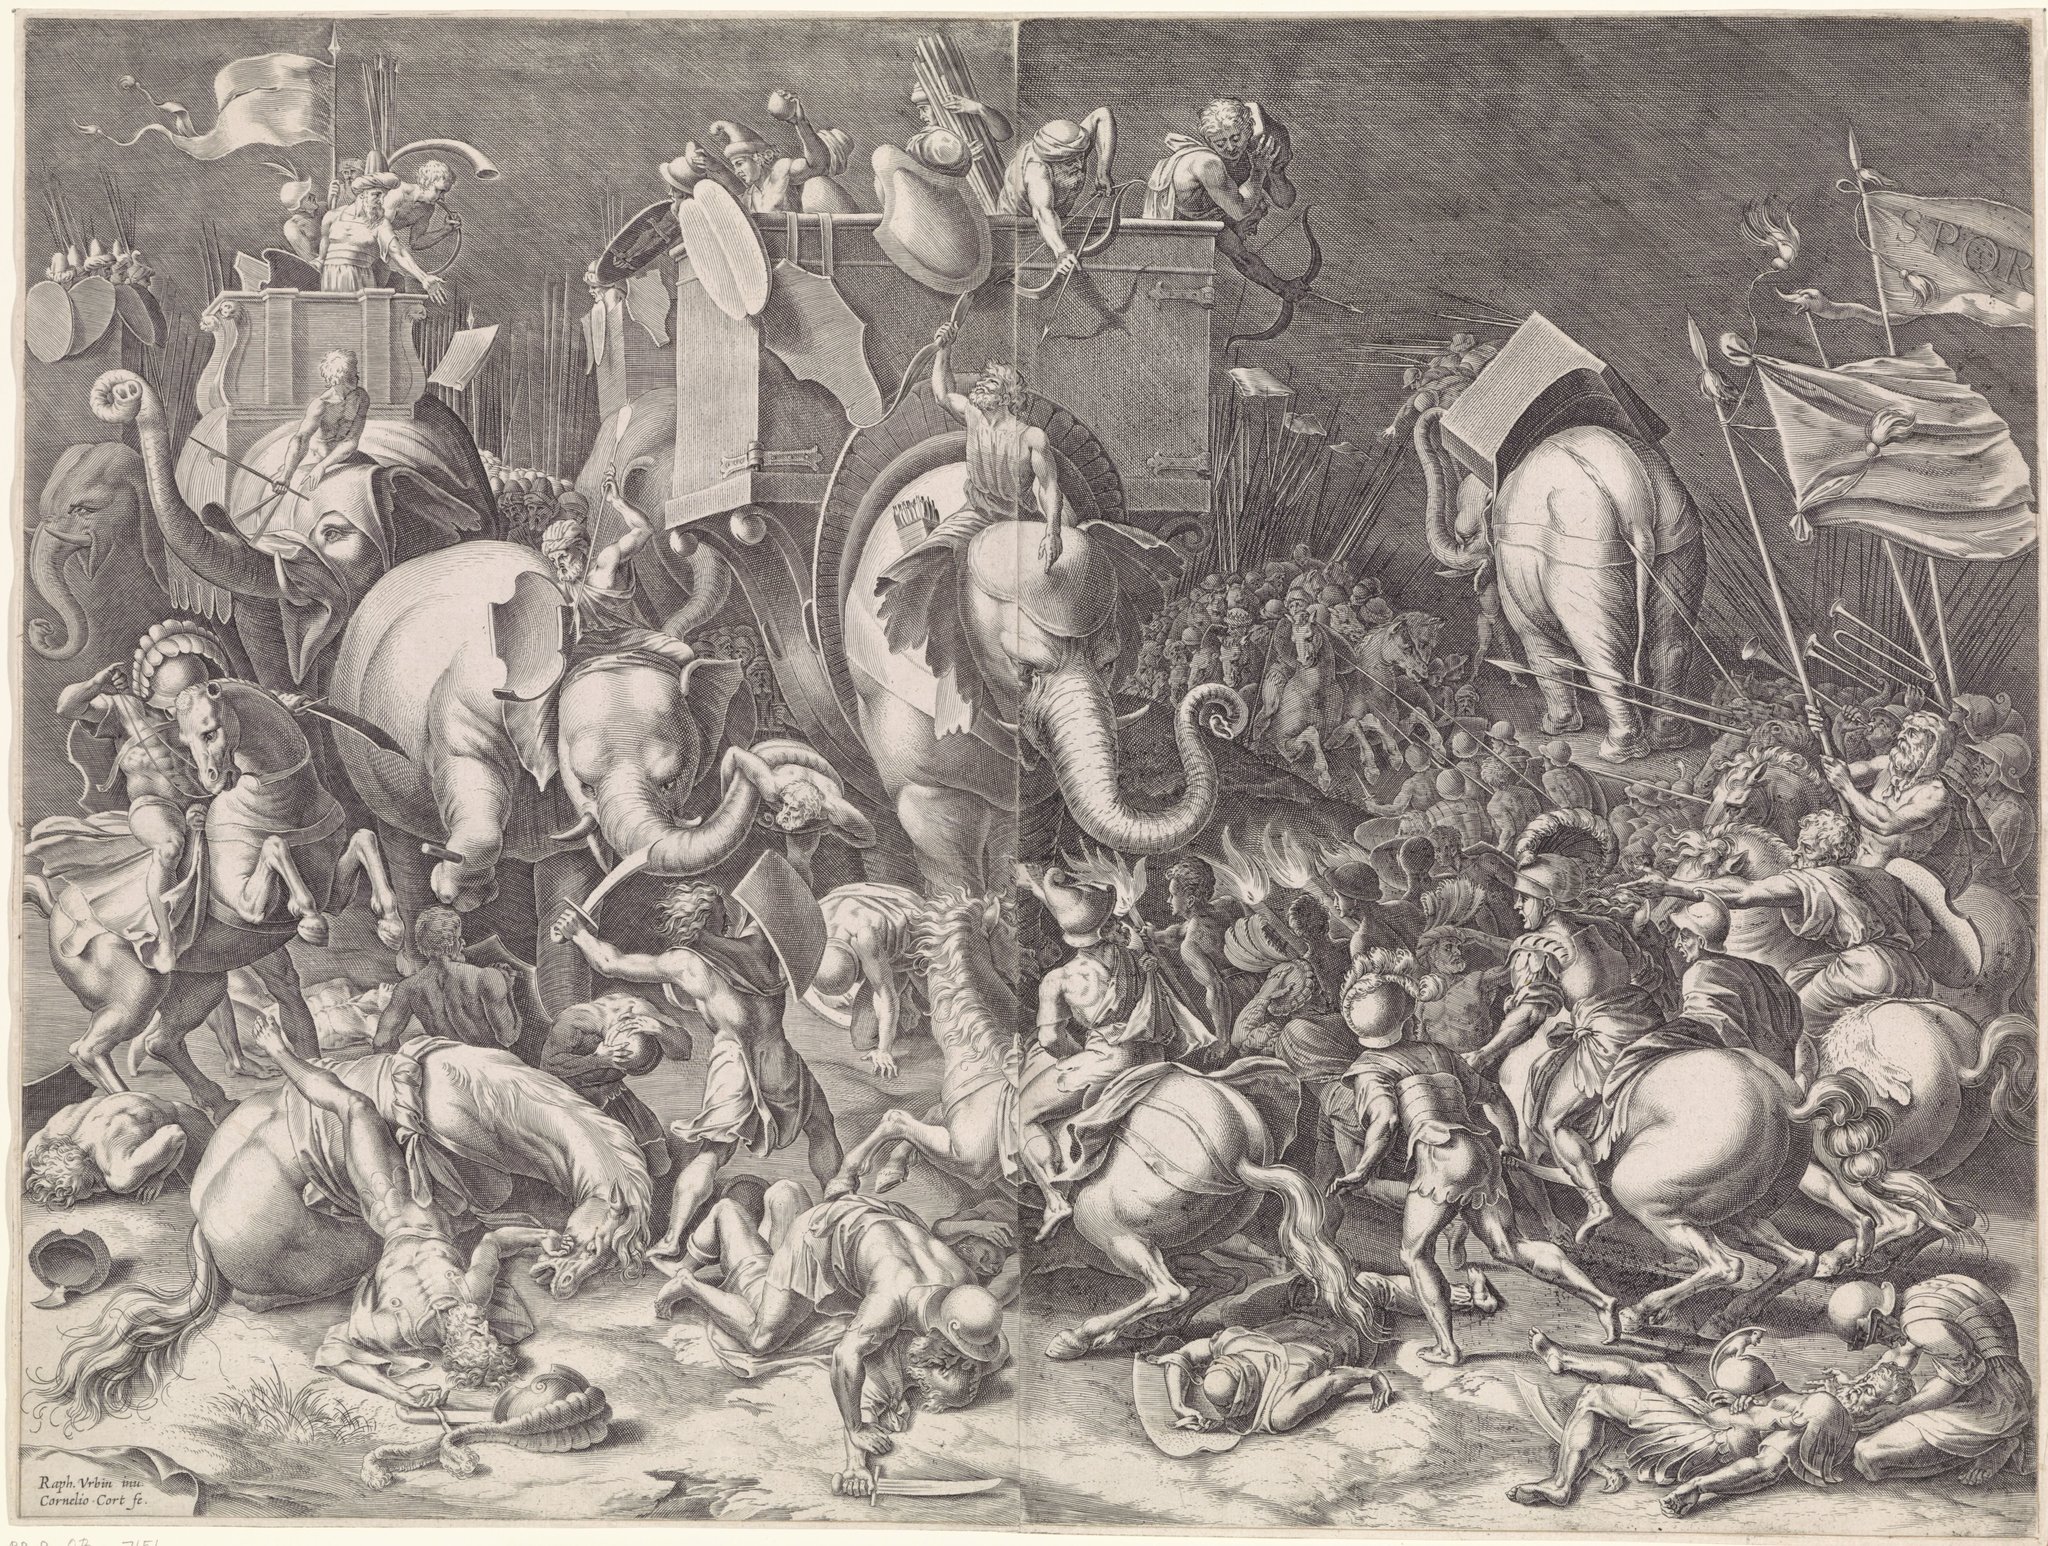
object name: print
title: Slag bij Zama tussen Scipio en Hannibal, bij nacht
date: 1567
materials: paper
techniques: engraving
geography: rome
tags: battle, (story of) p. cornelius scipio africanus major, hannibal crosses the alps with his army and his elephants, trunked animals: elephant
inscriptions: collector's mark: Lugt 240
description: Veldslag tussen Rome en Carthago, onder leiding van Scipio en Hannibal. Het Carthaagse leger rijdt op olifanten, de Romeinen zijn te voet en te paard maar kunnen Carthago uiteindelijk verslaan. Door een misverstand laat deze prent de slag bij nacht zien, de veldslag vond echter overdag plaats.